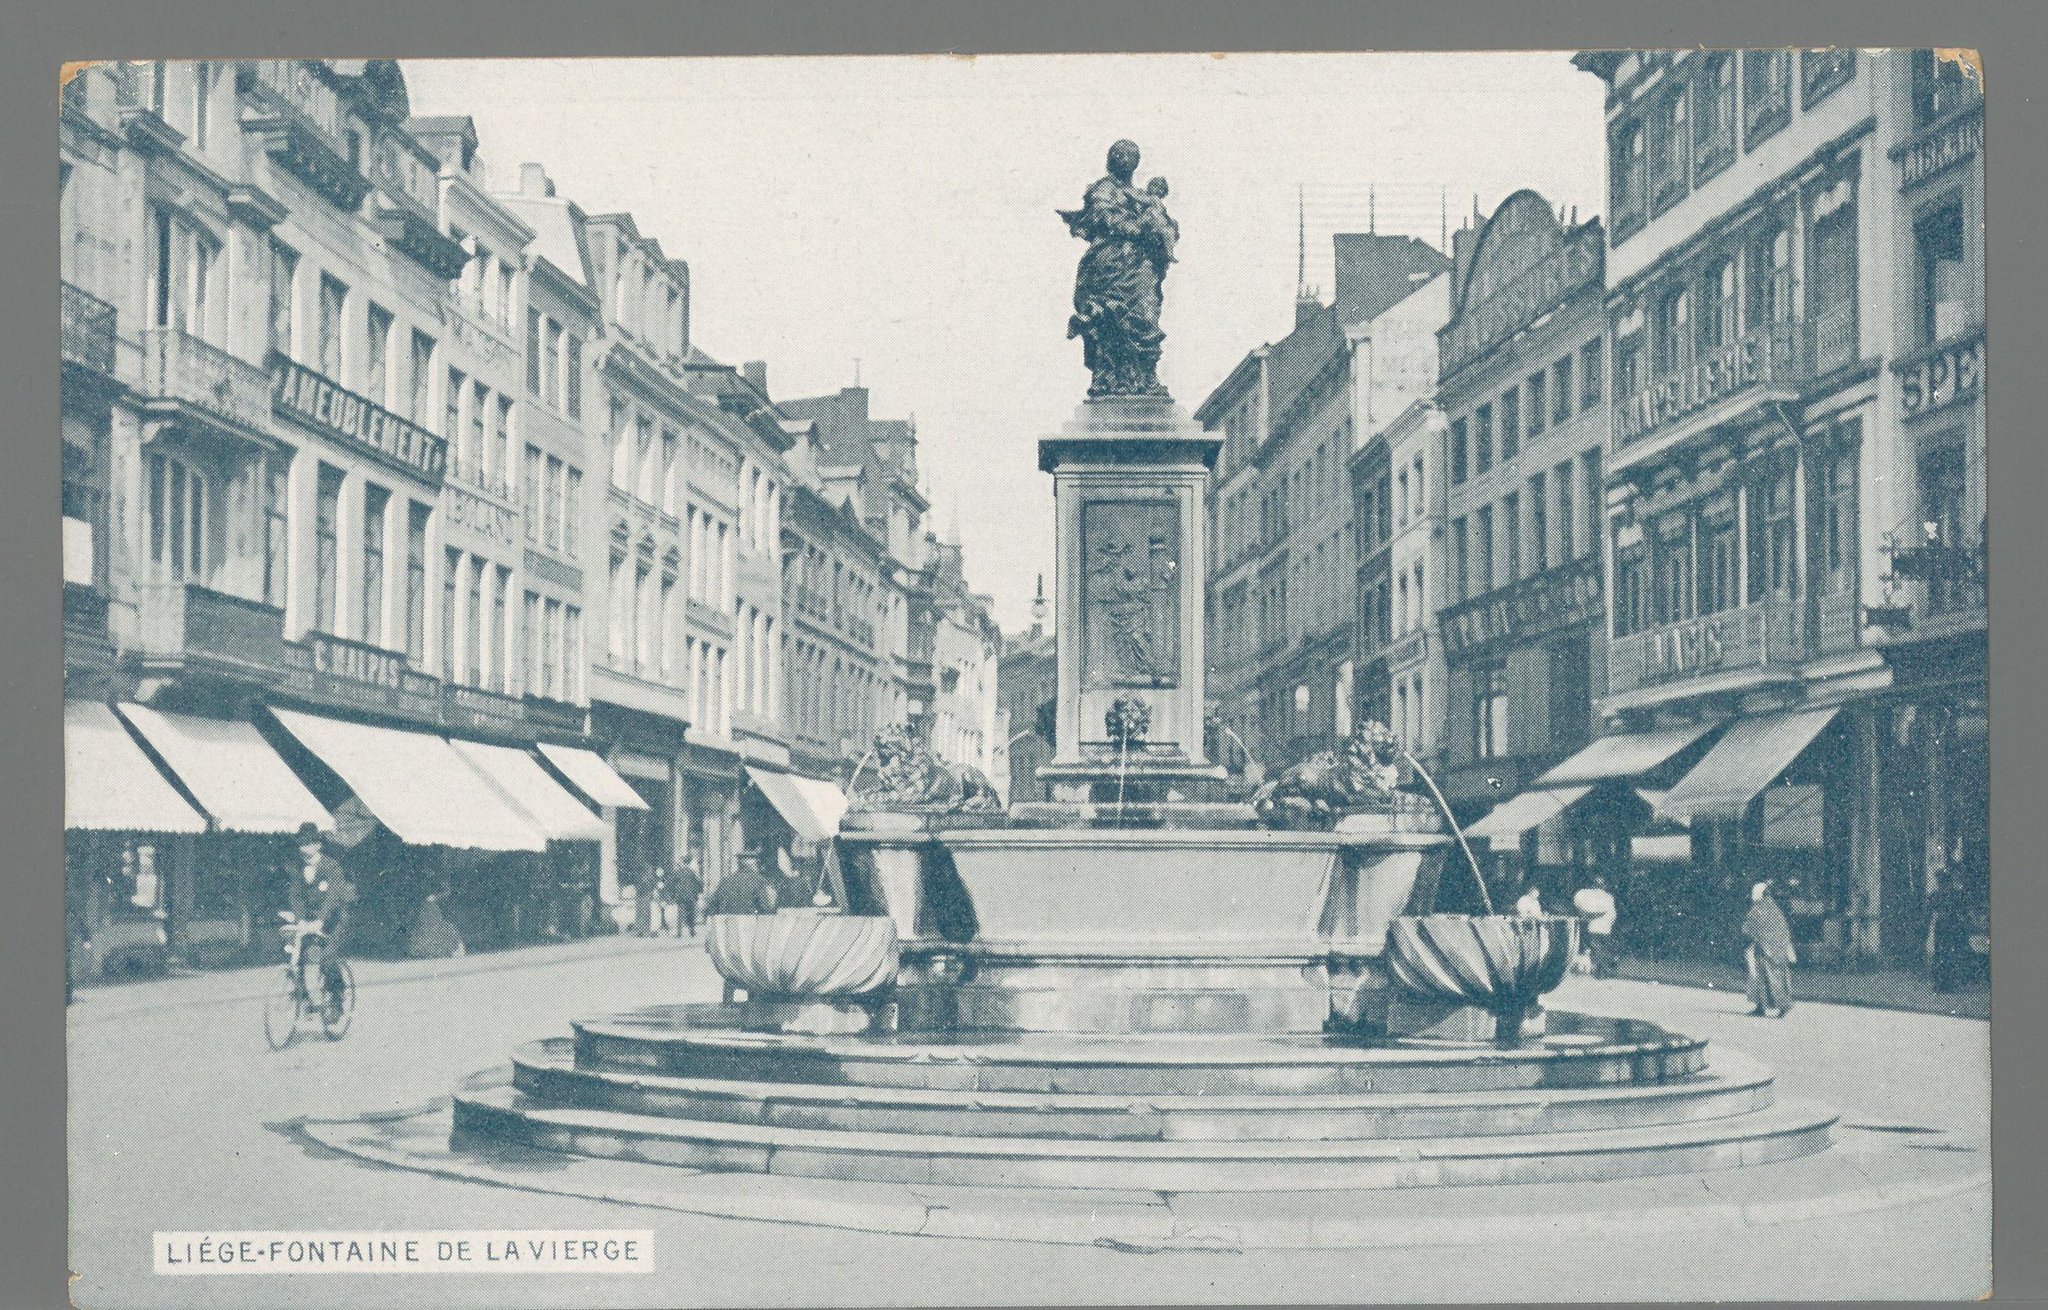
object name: photomechanical print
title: Liège. Fontaine de la Vierge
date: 1909-1913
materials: cardboard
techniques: autotype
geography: antwerp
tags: ornamental fountain, square, place, circus, etc. (+ city(-scape) with figures, staffage), liège